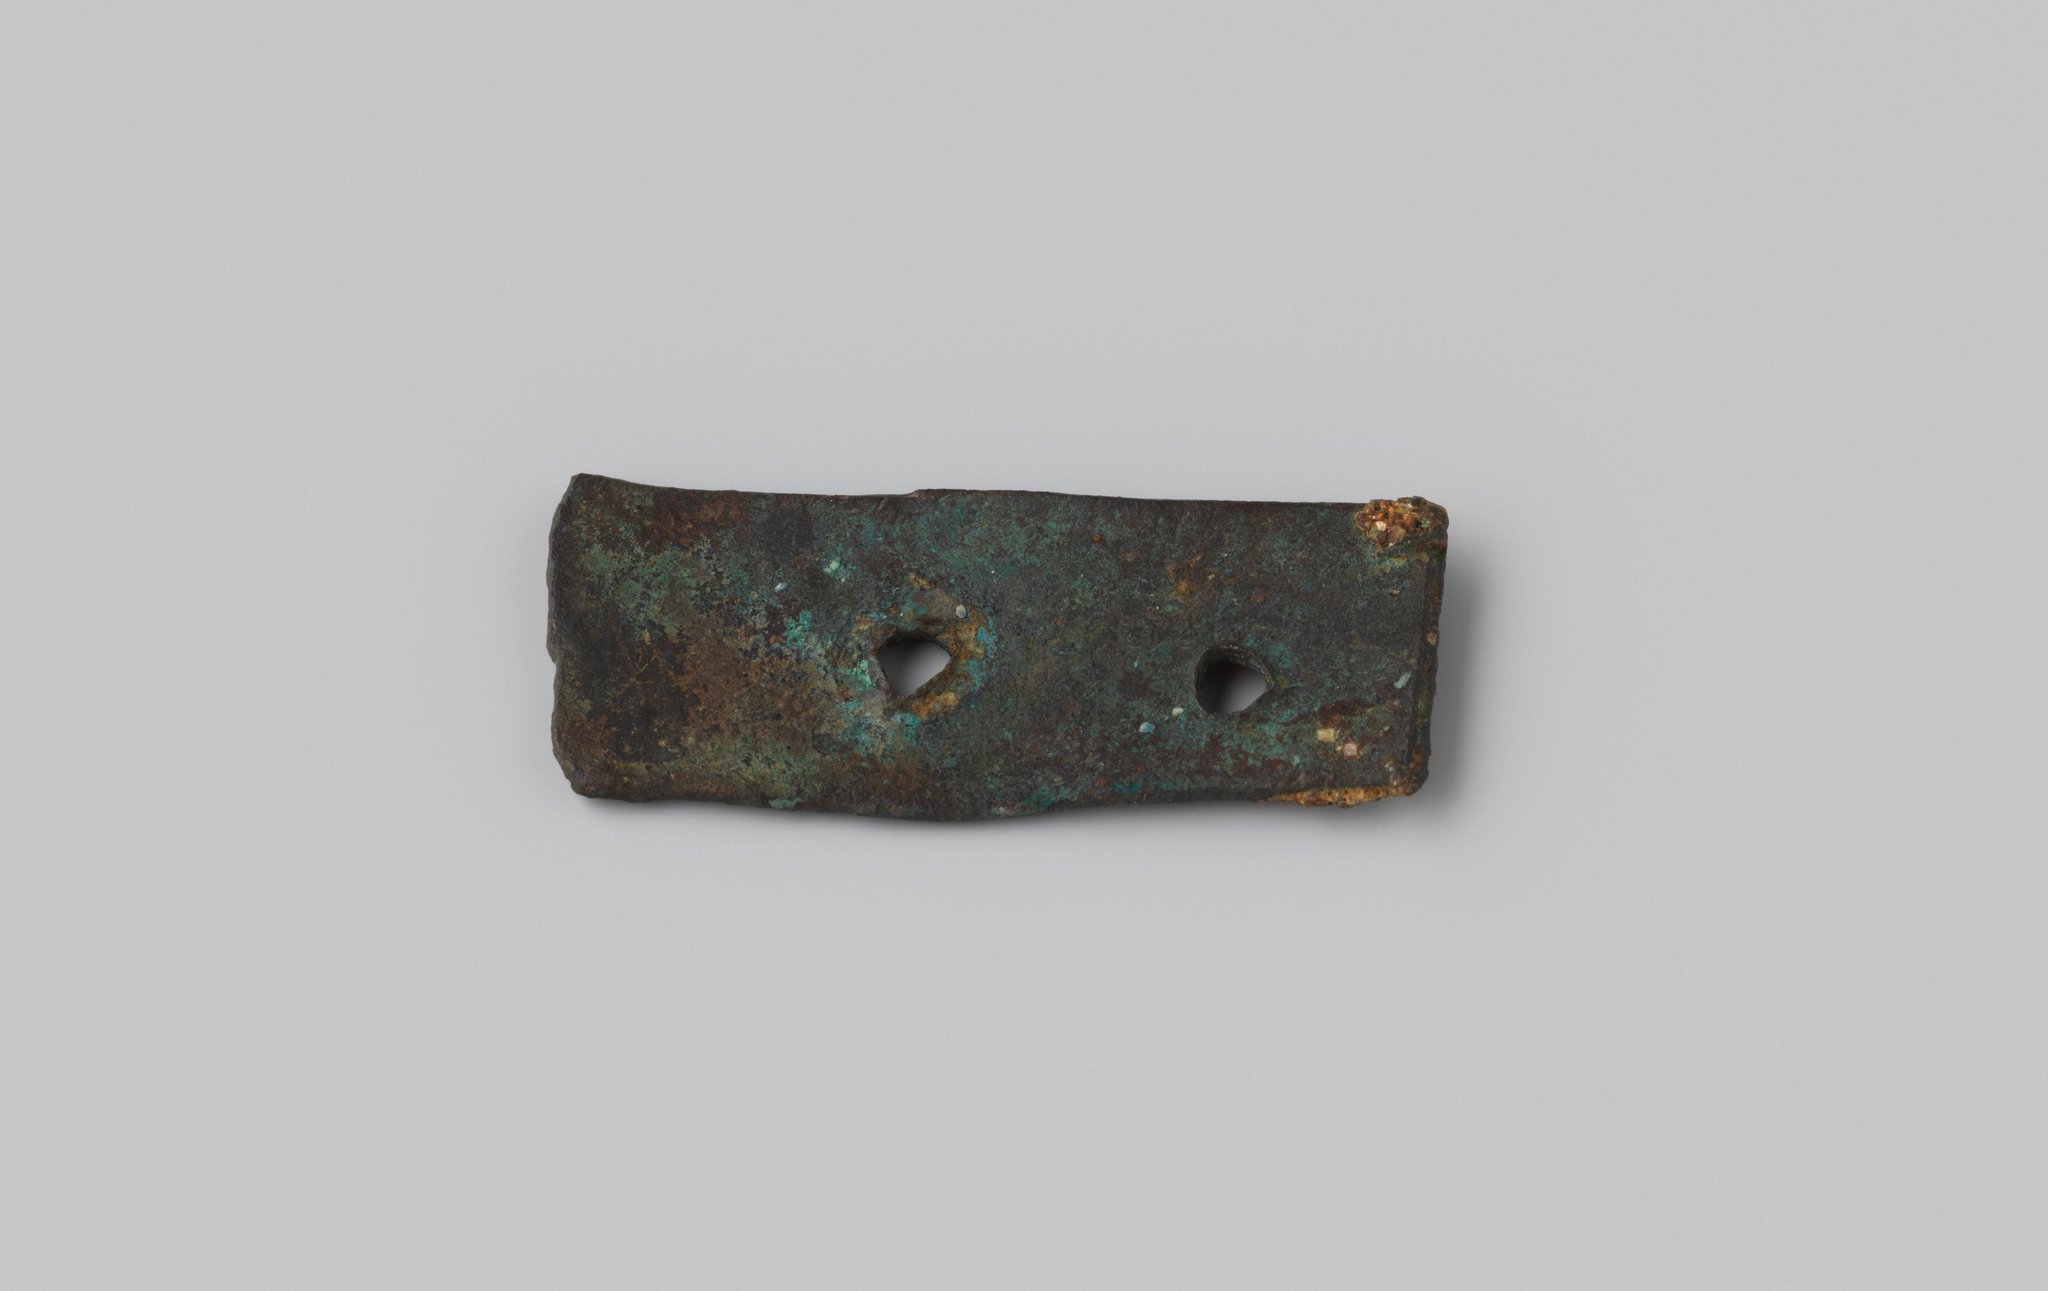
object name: part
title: Onderdeel of hulpstuk afkomstig uit het wrak van de Oost-Indiëvaarder Hollandia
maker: Anonymous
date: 1700-1743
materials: copper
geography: netherlands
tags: verenigde oostindische compagnie, hollandia (schip)